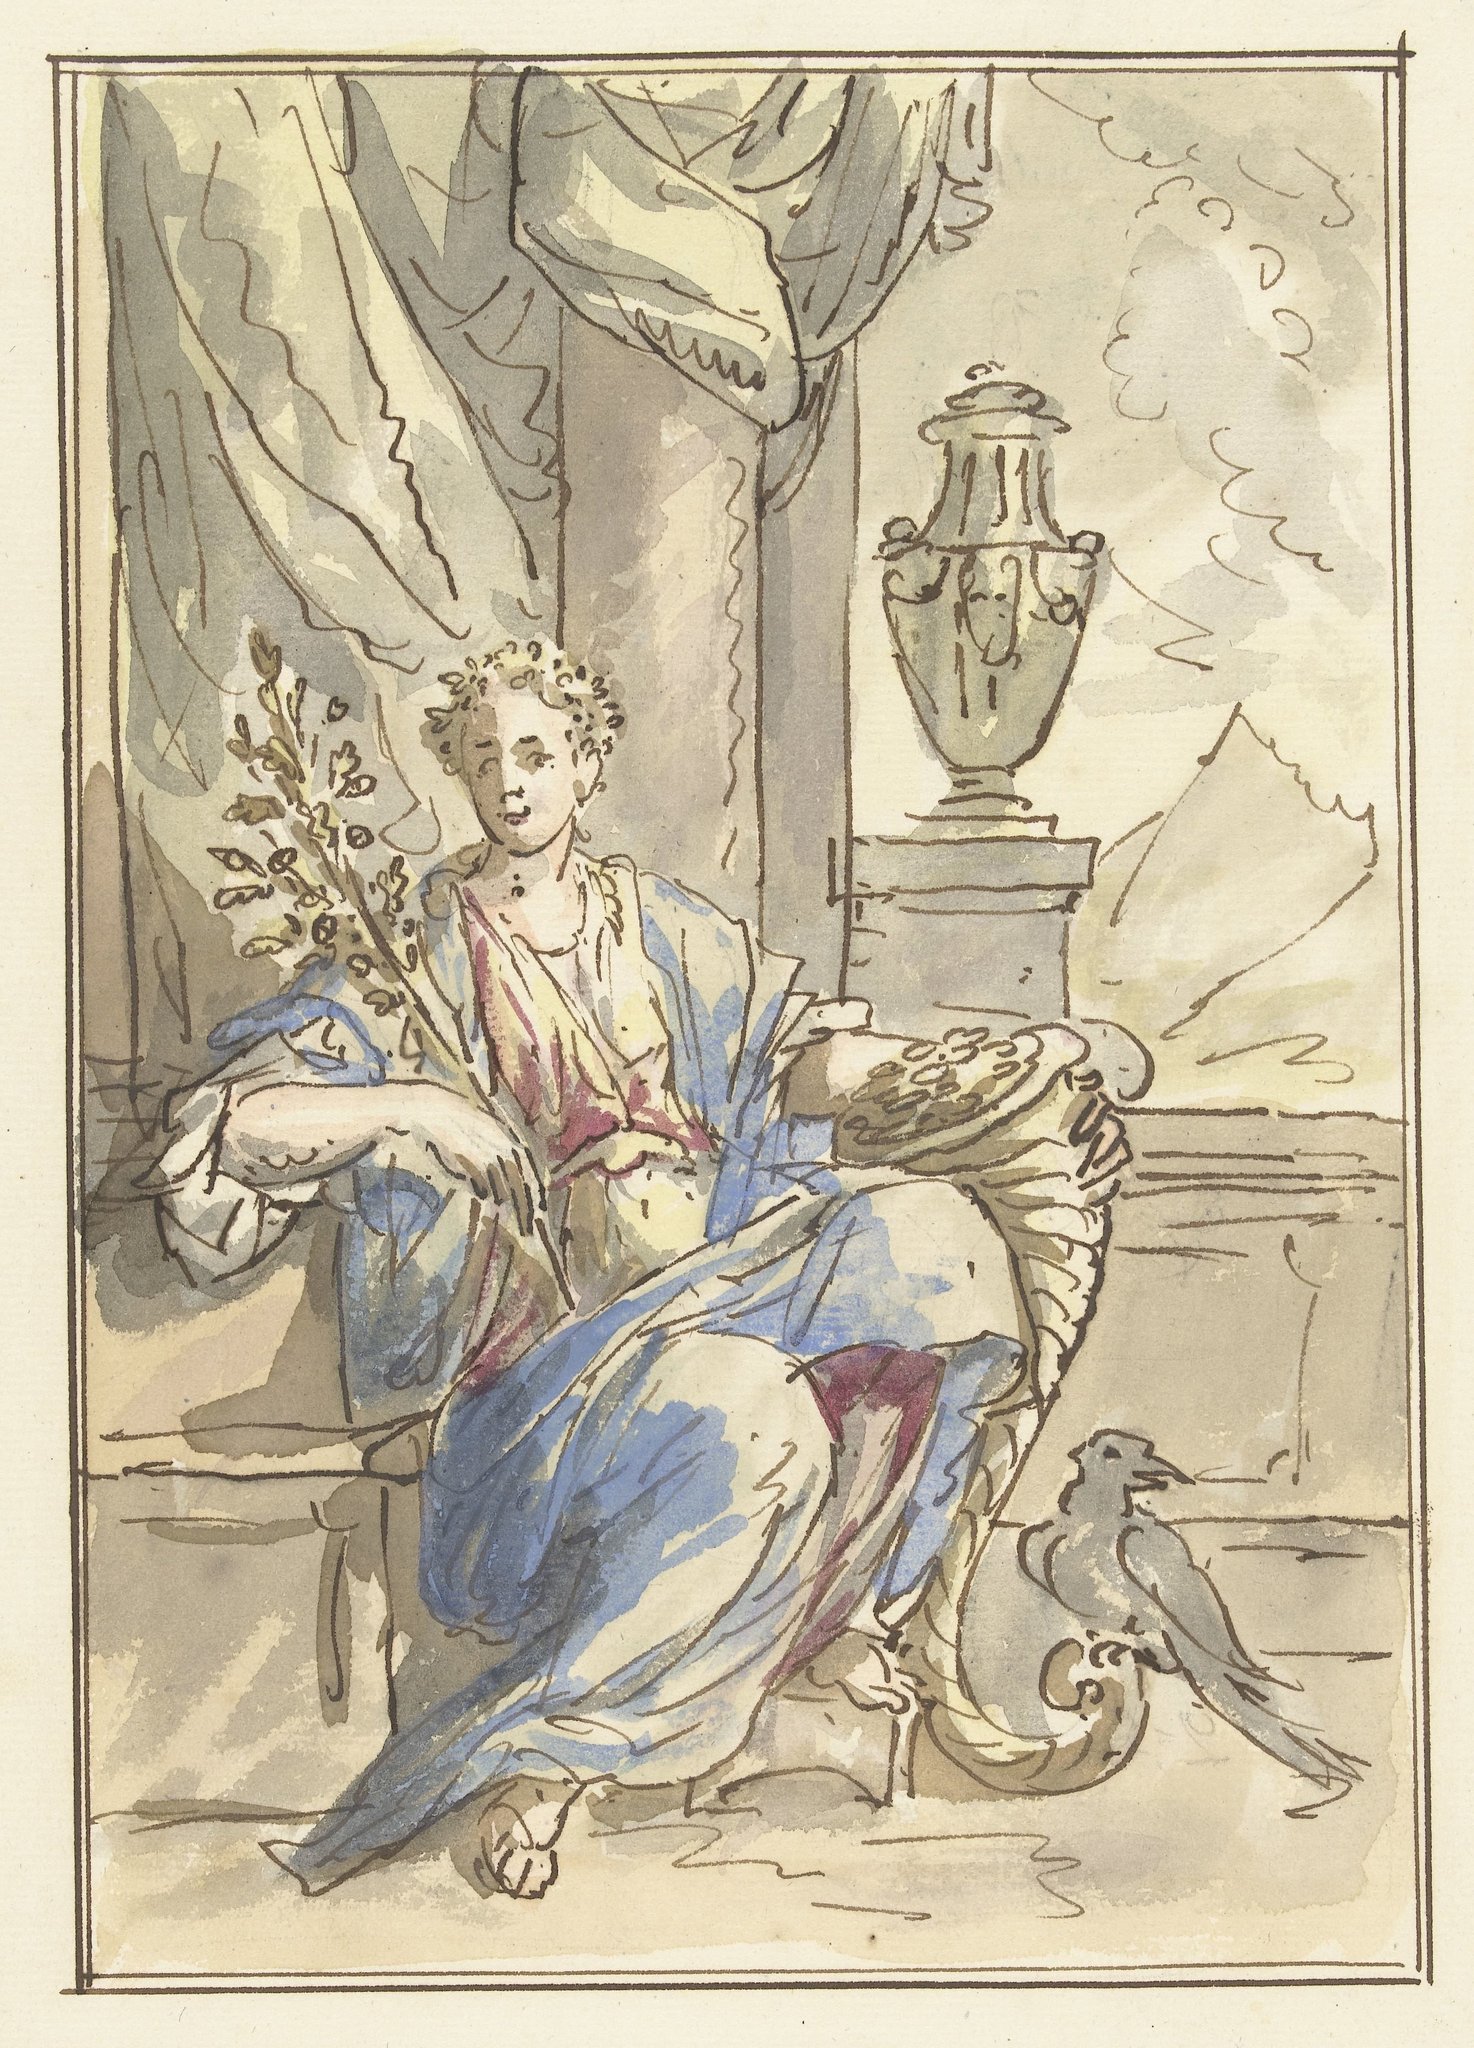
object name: design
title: Allegorie van het Gelukkig Leven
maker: elias van nijmegen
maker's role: draughtsman, painter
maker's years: 1667-1755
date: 1677-1755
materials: ink, paper, pencil, watercolor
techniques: brush, pen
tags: welfare, prosperity; 'felicità publica', 'prosperità della vita', 'salute' (ripa) (+ abstract concept represented by female figure)